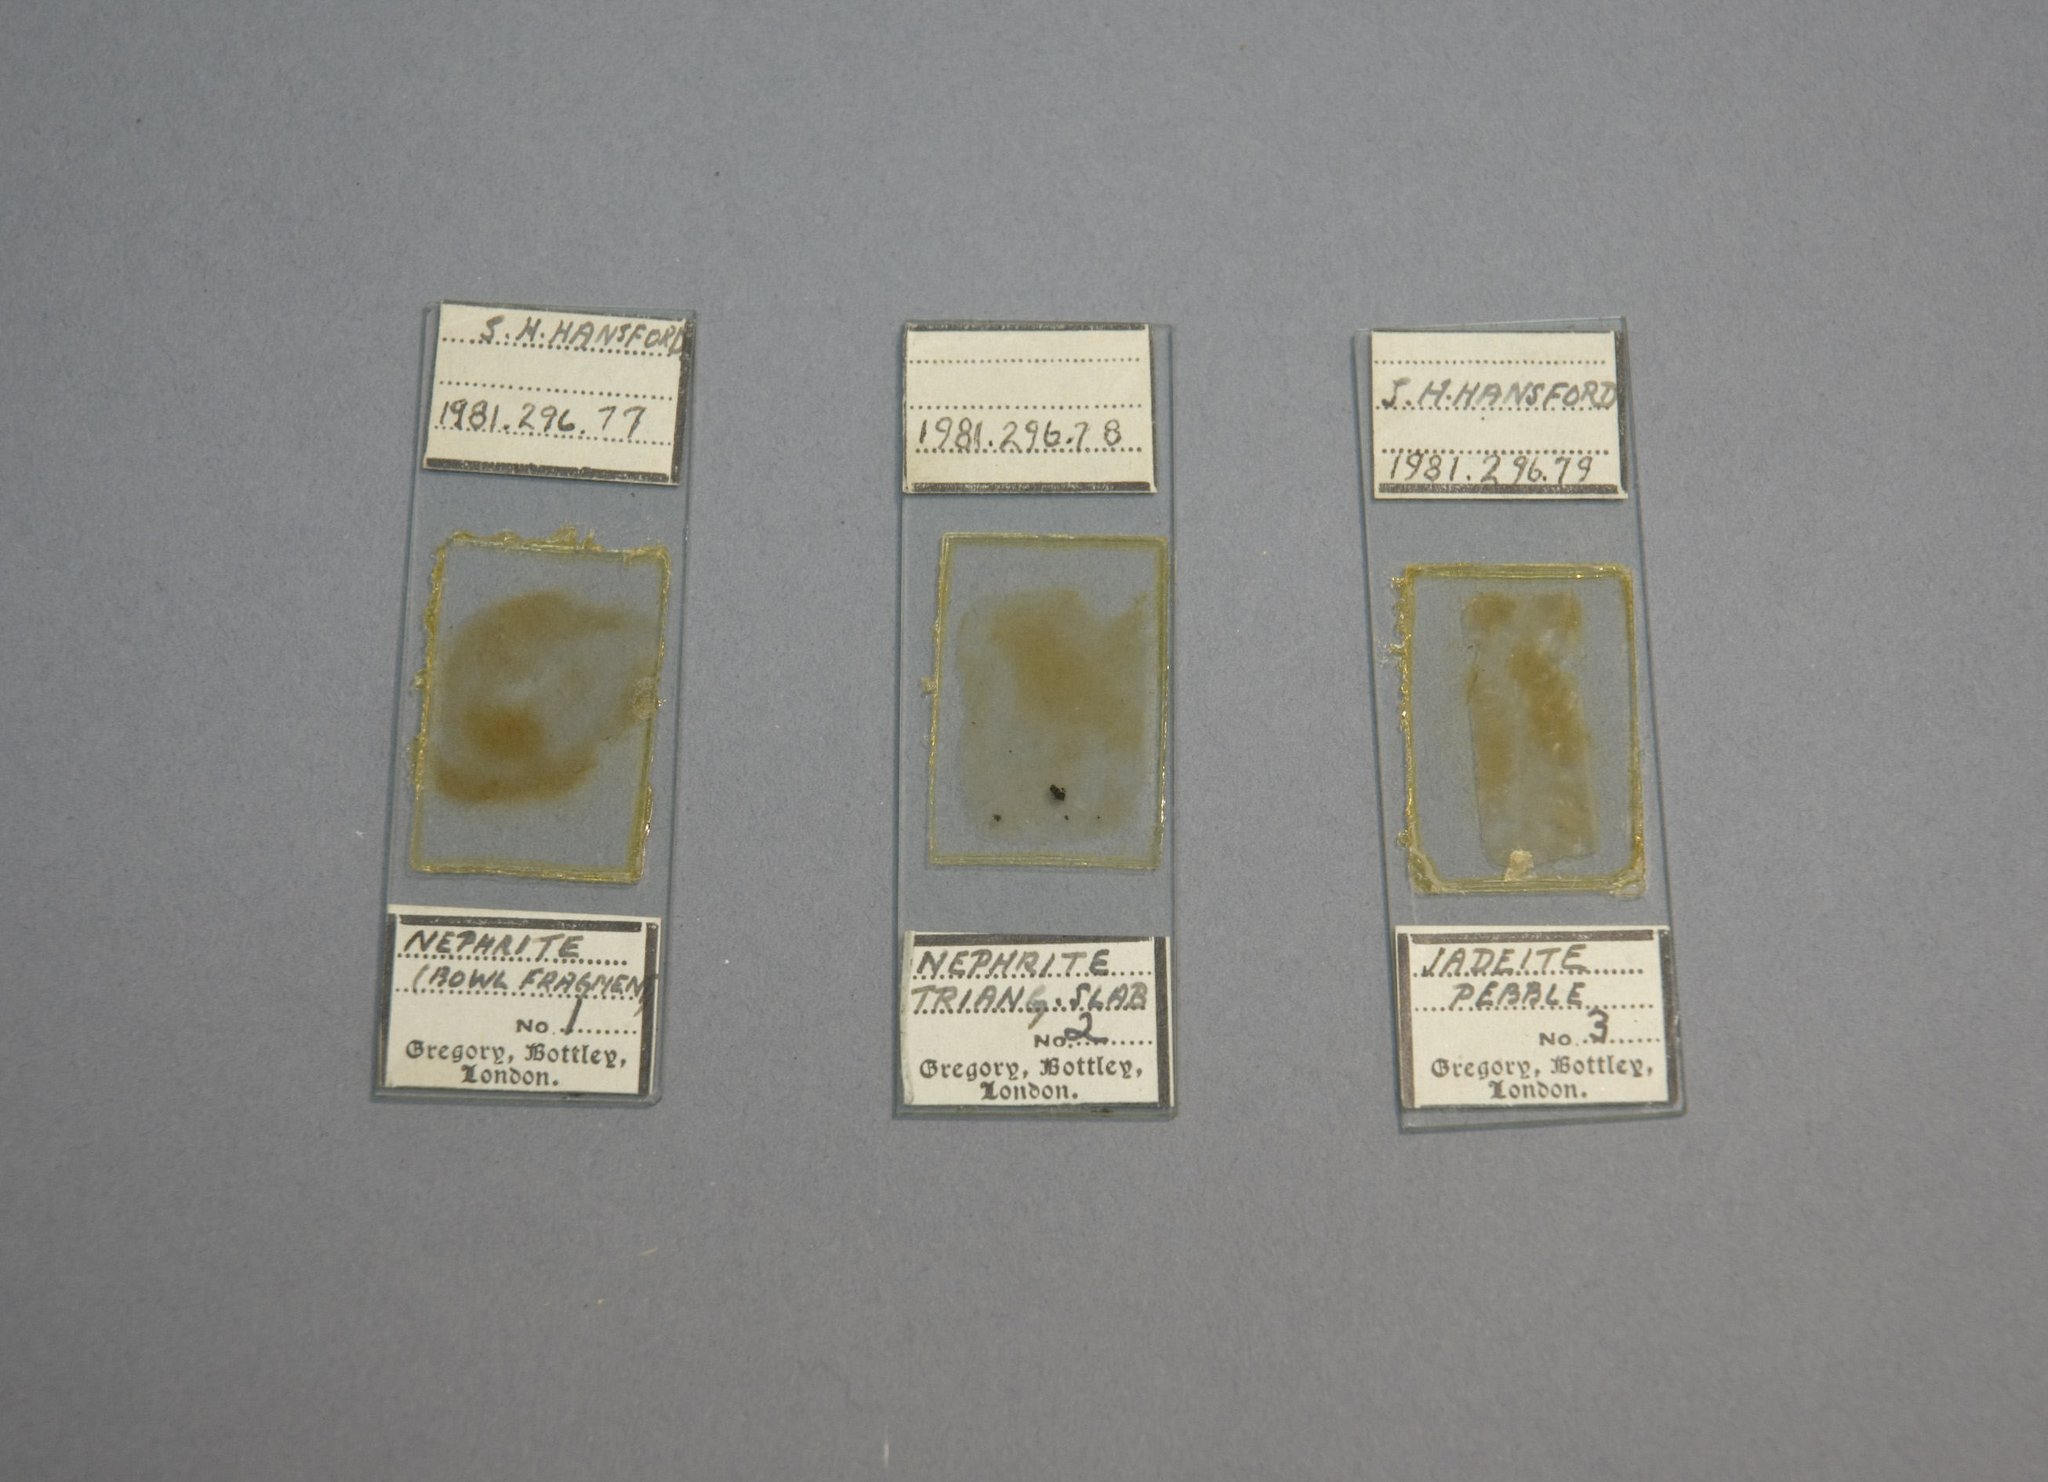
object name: jade carving material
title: Section of Nephrite Mounted in a Microscope Slide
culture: chinese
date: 1901-2000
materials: jade